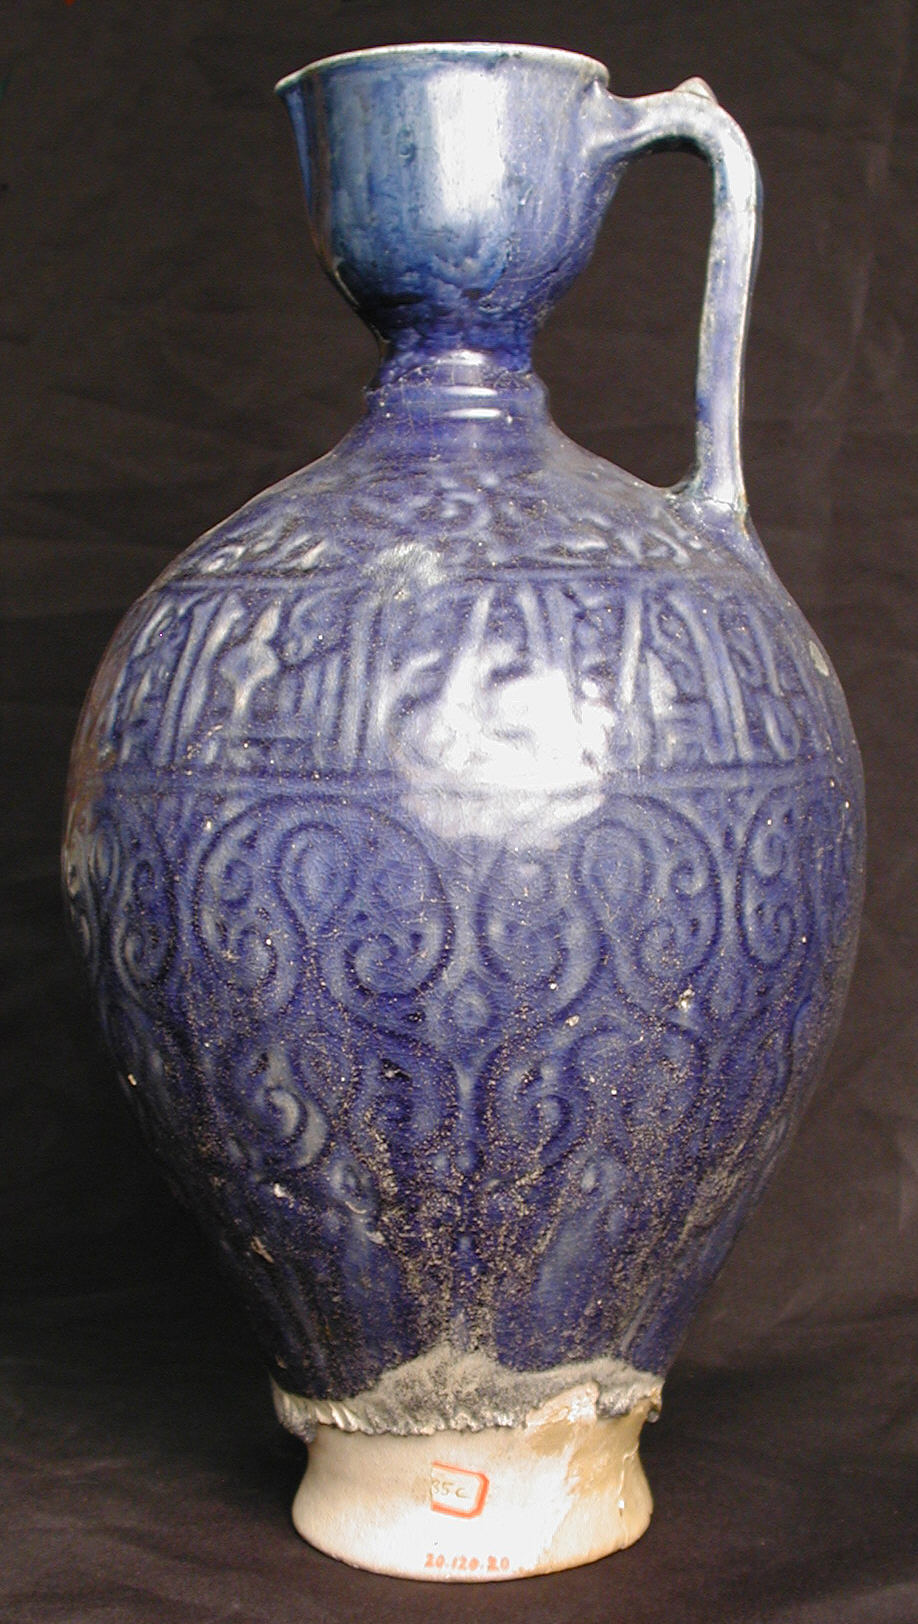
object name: ewer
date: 1101-1300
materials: stonepaste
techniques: glazing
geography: iran